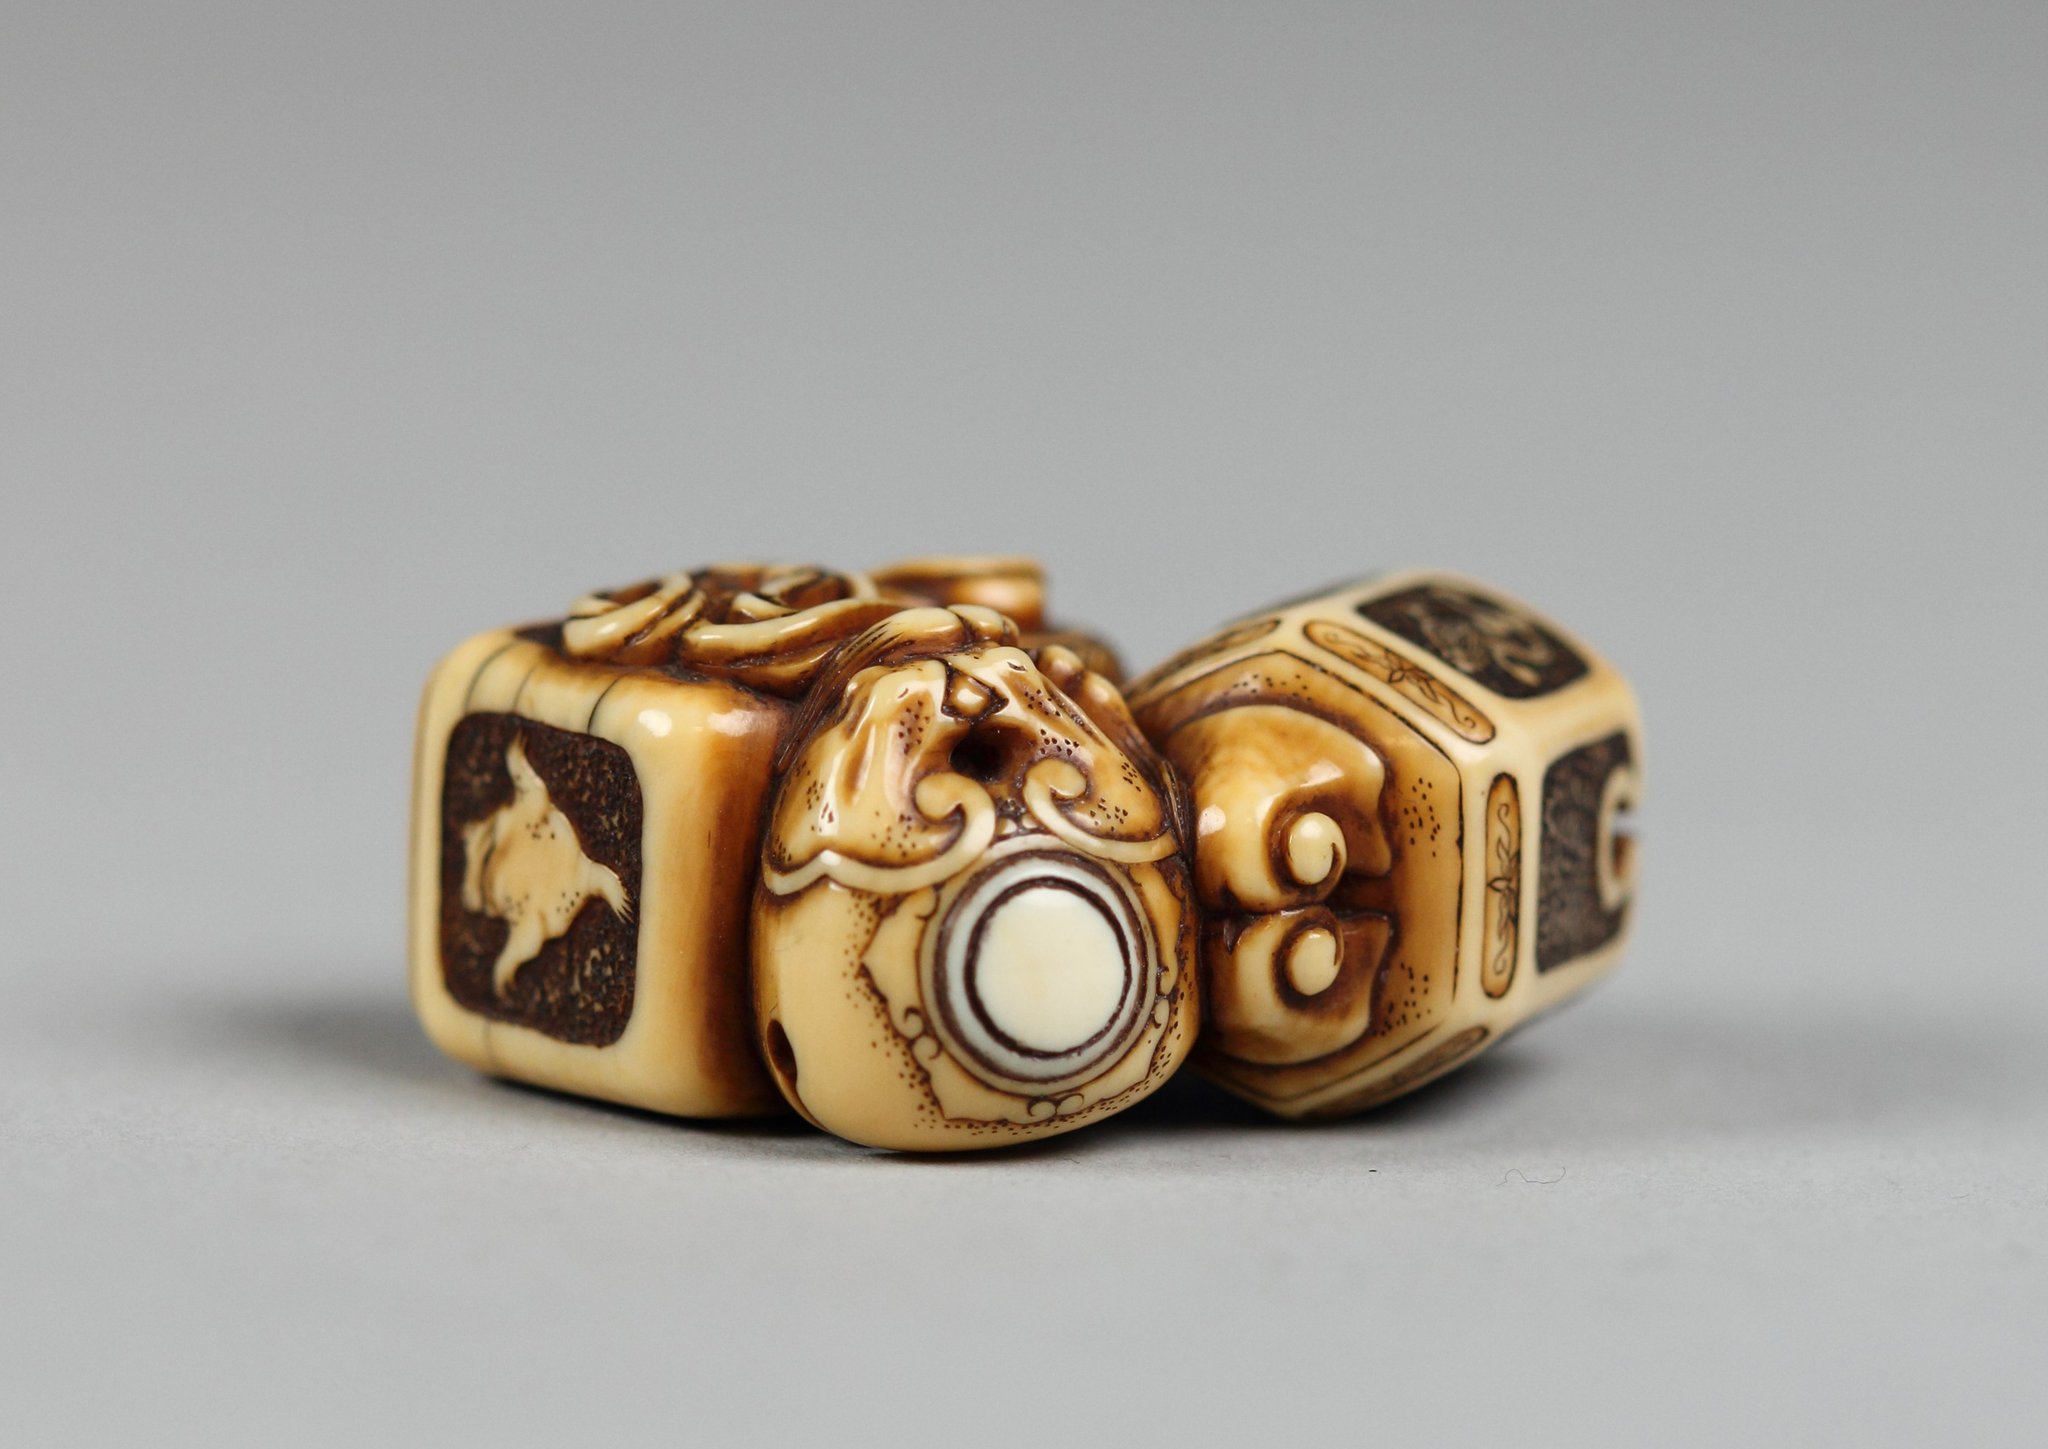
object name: netsuke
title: Netsuke of Four Bells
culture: japanese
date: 1701-1900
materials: ivory